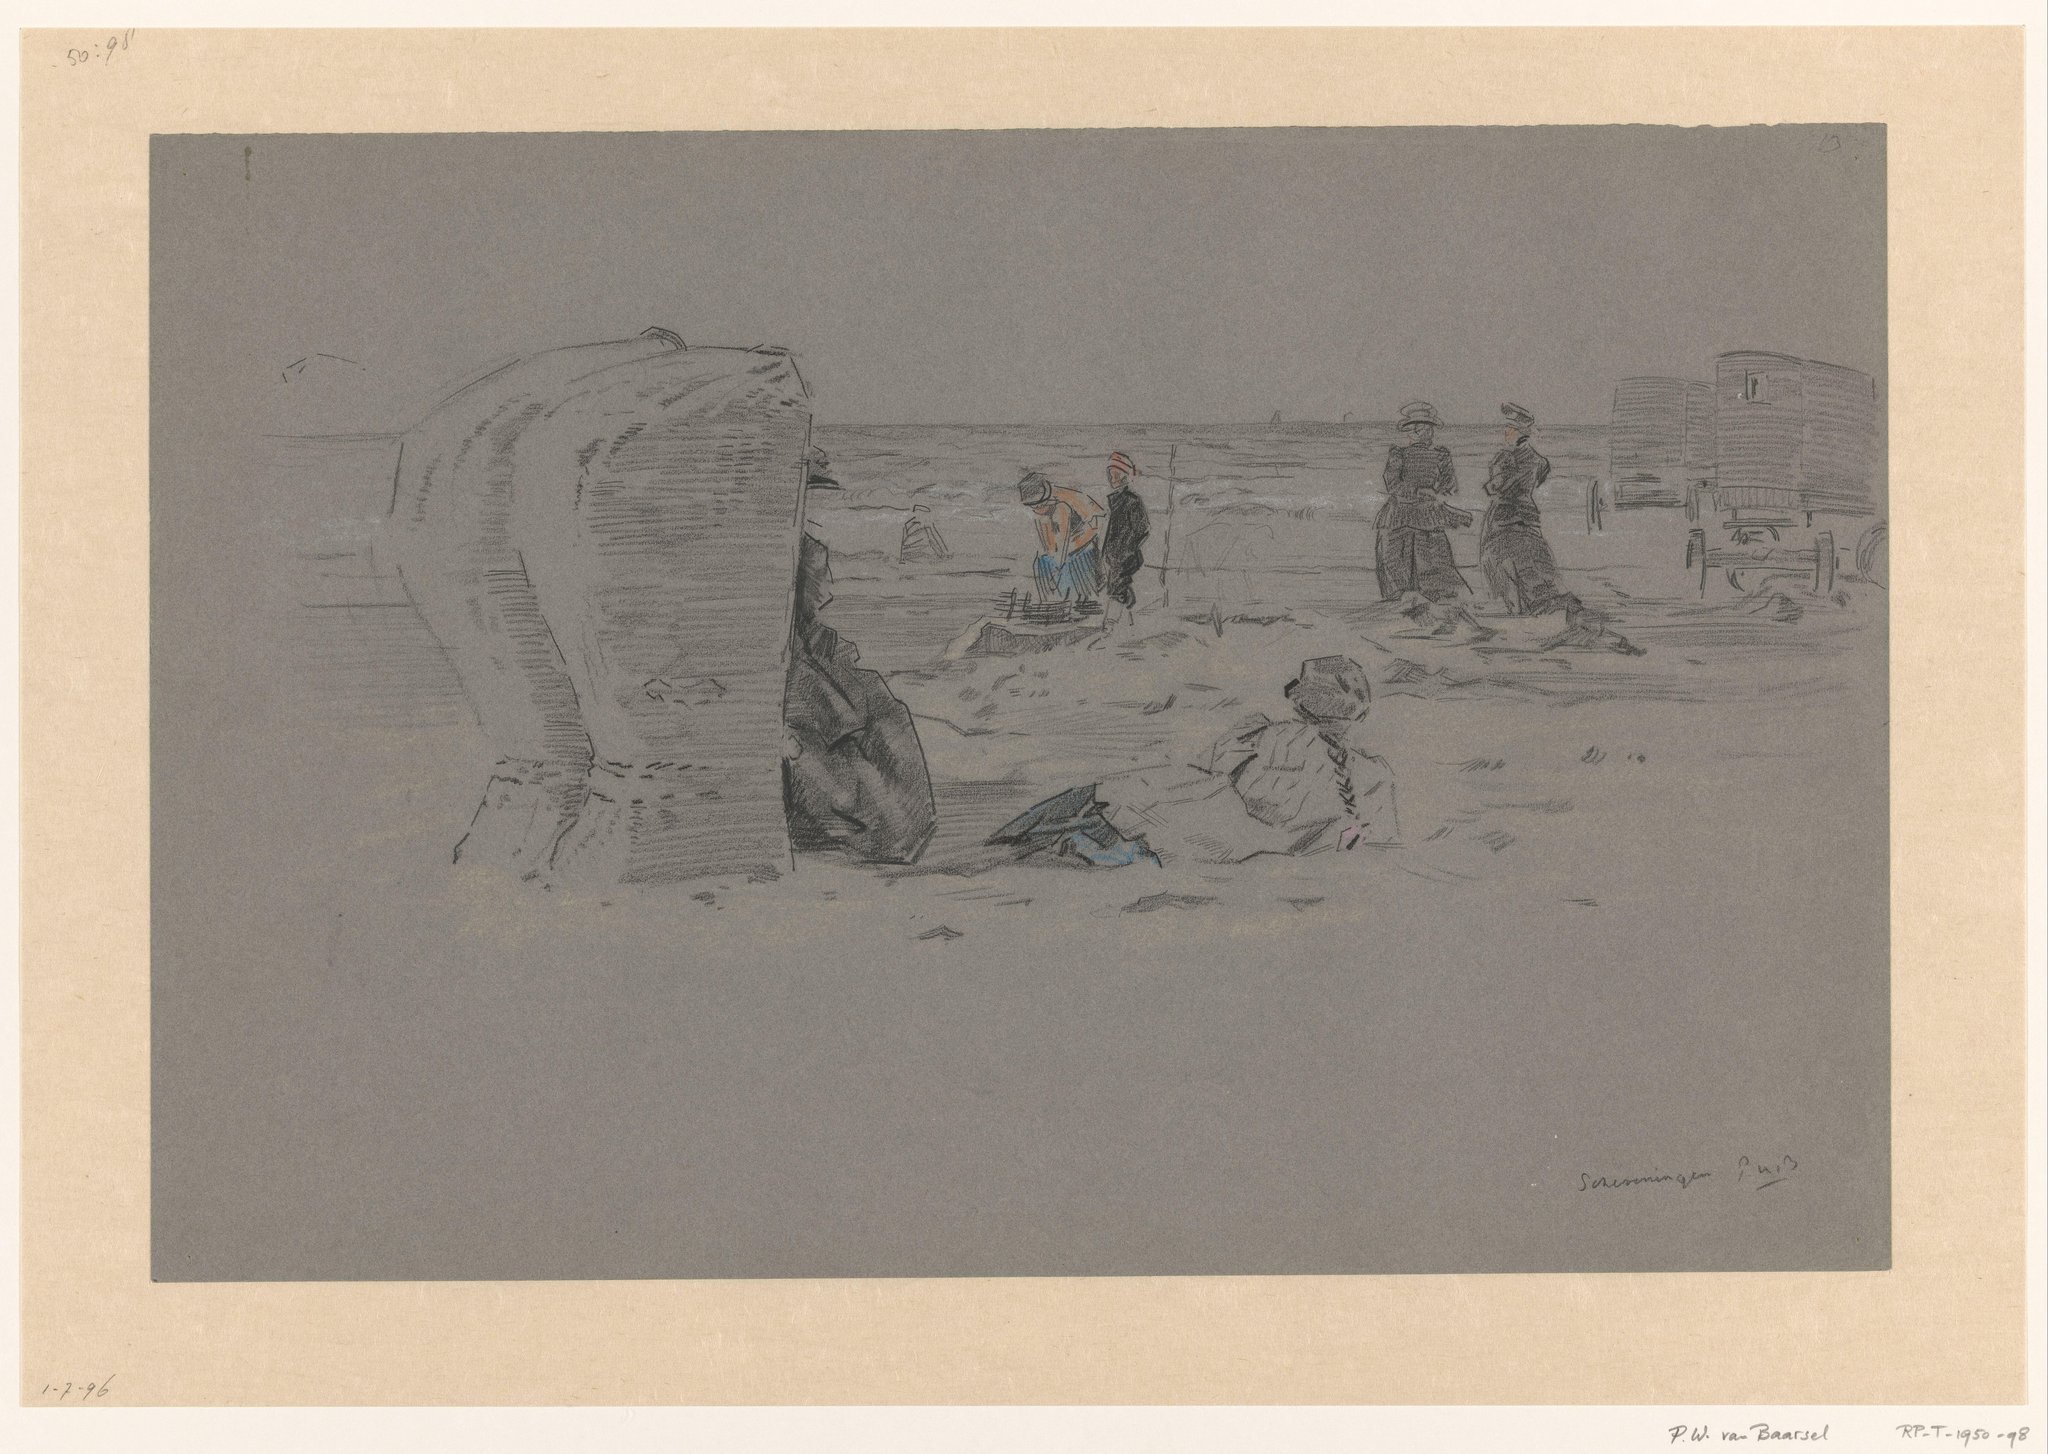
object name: drawing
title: Strandgezicht te Scheveningen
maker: pieter willem van baarsel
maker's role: draughtsman, painter, print maker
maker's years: 1879-1949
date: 1889-1949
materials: chalk, paper, pastel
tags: beach